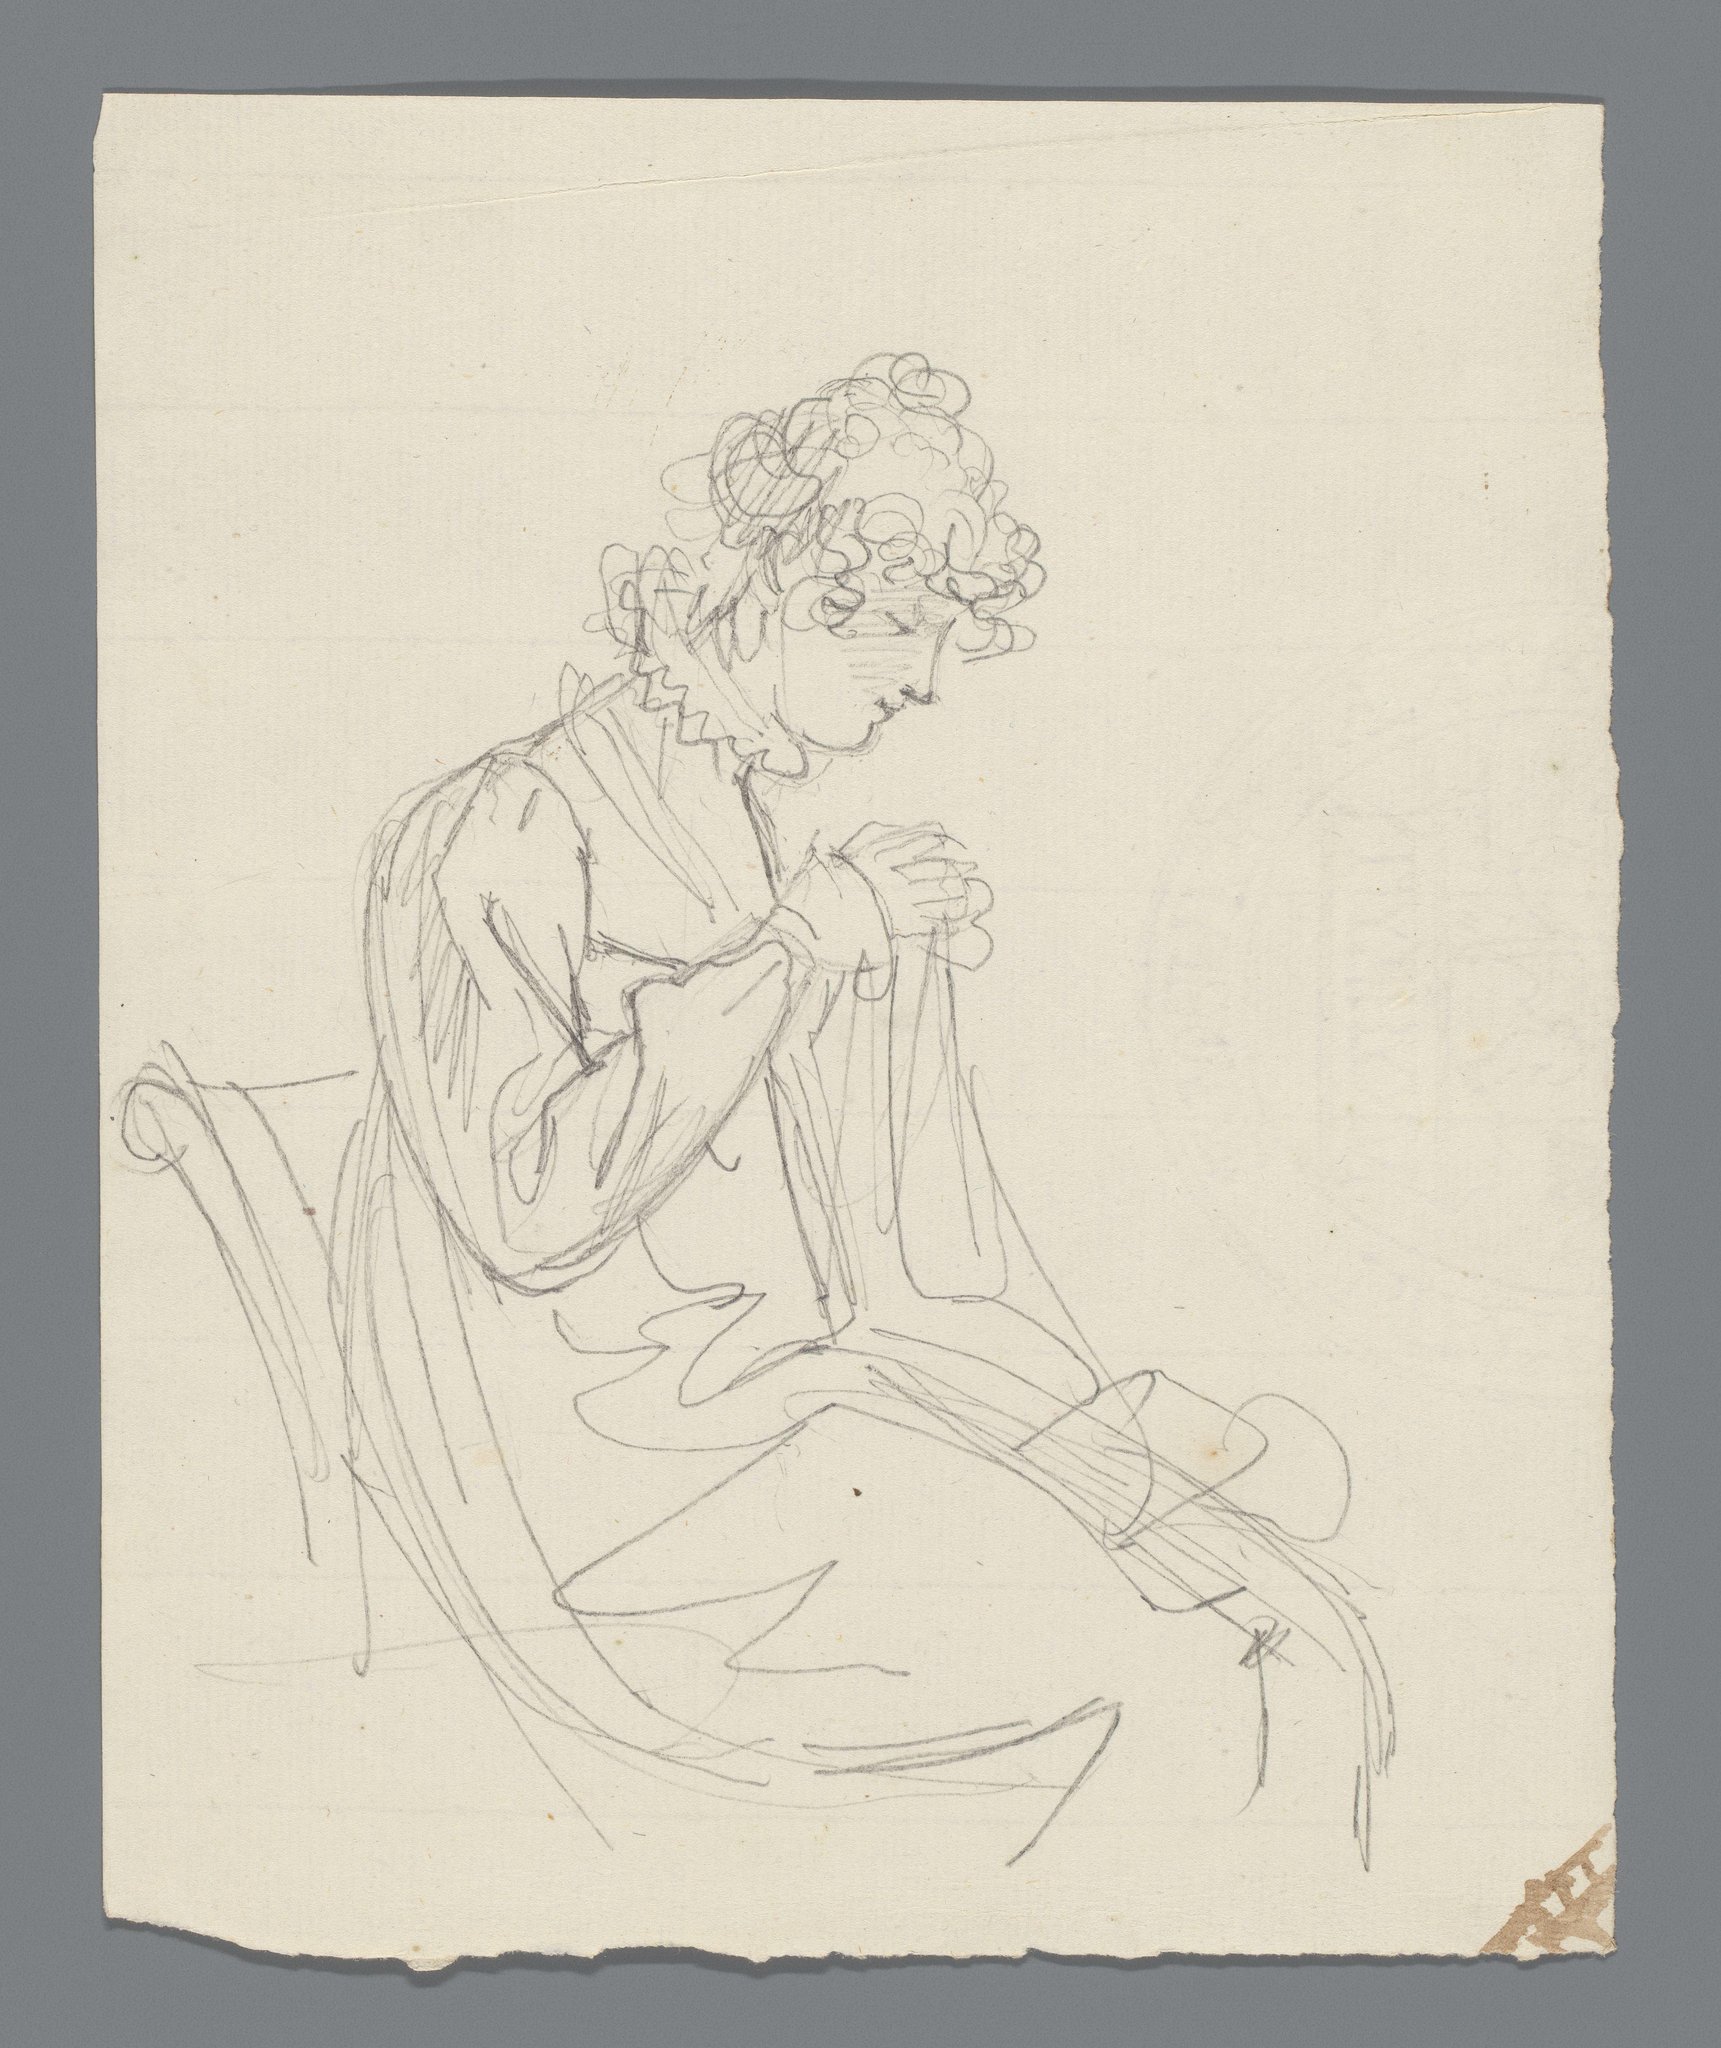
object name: drawing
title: Handwerkend meisje, naar rechts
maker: david pièrre giottino humbert de superville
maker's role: draughtsman, painter, print maker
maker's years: 1770-1849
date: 1780-1849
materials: paper, pencil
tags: (other forms of) needlework, e.g.: crocheting, knitting, embroidering